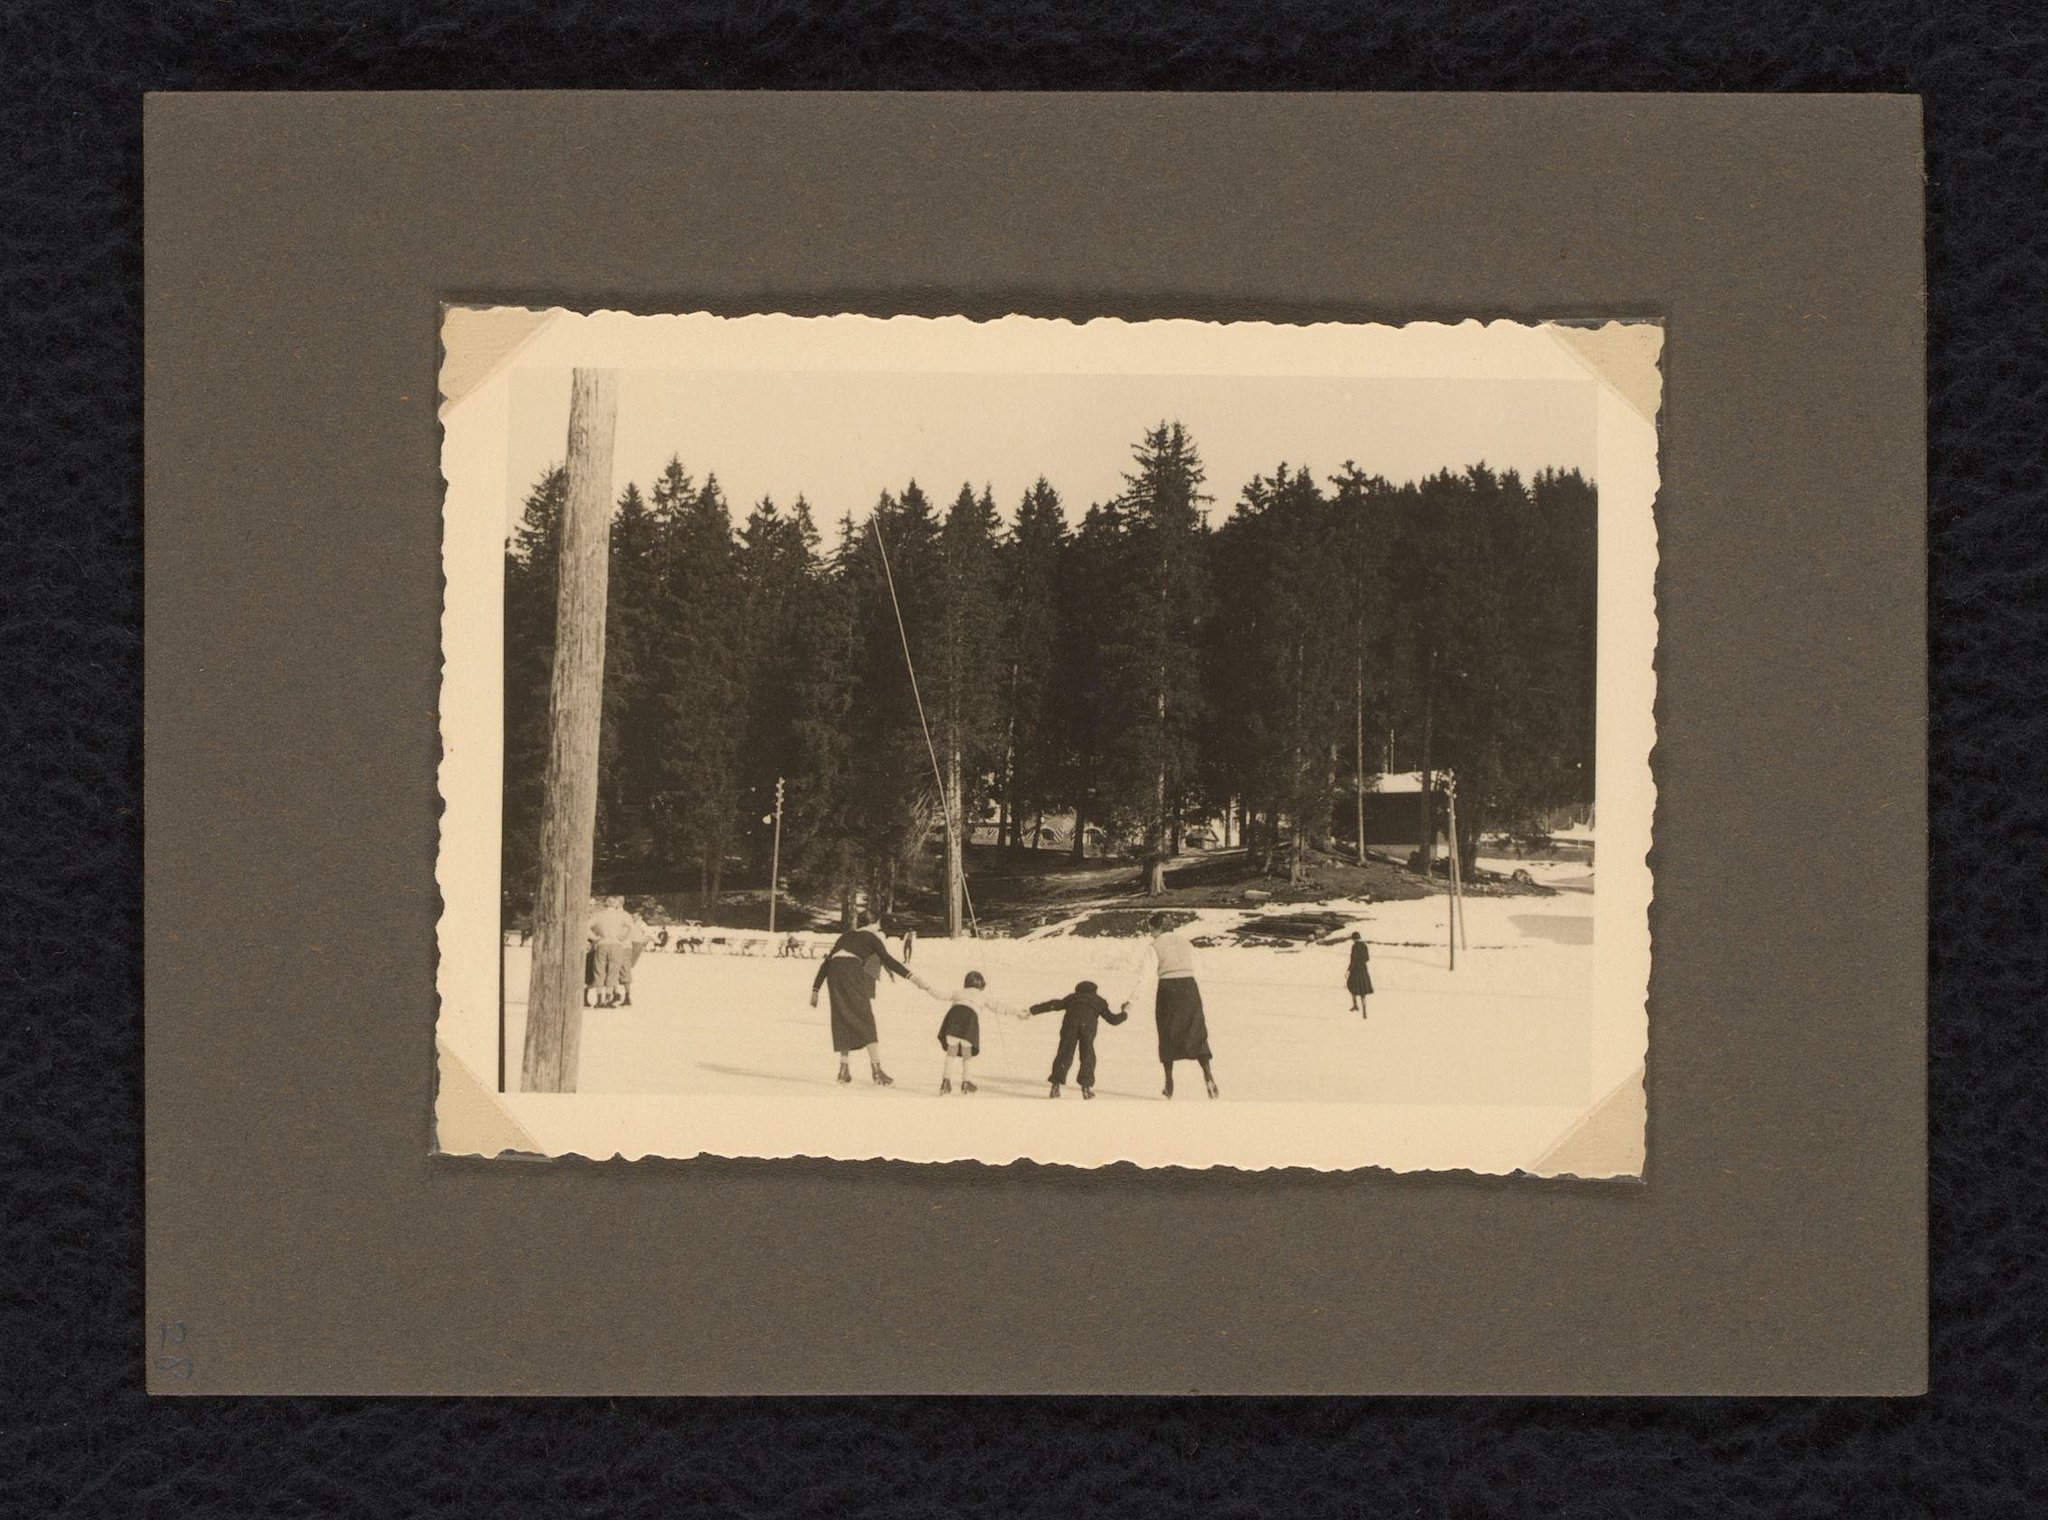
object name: album leaf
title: Arrenslee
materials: cardboard, photographic support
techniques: gelatin silver print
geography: lenzerheide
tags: the family travelling, on holiday, snow, sledge, sleigh (winter sports)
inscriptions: date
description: Albumblad met een foto van een arrenslee. Onderdeel van het fotoalbum met vakantiefoto's Lenzerheide, 1934.